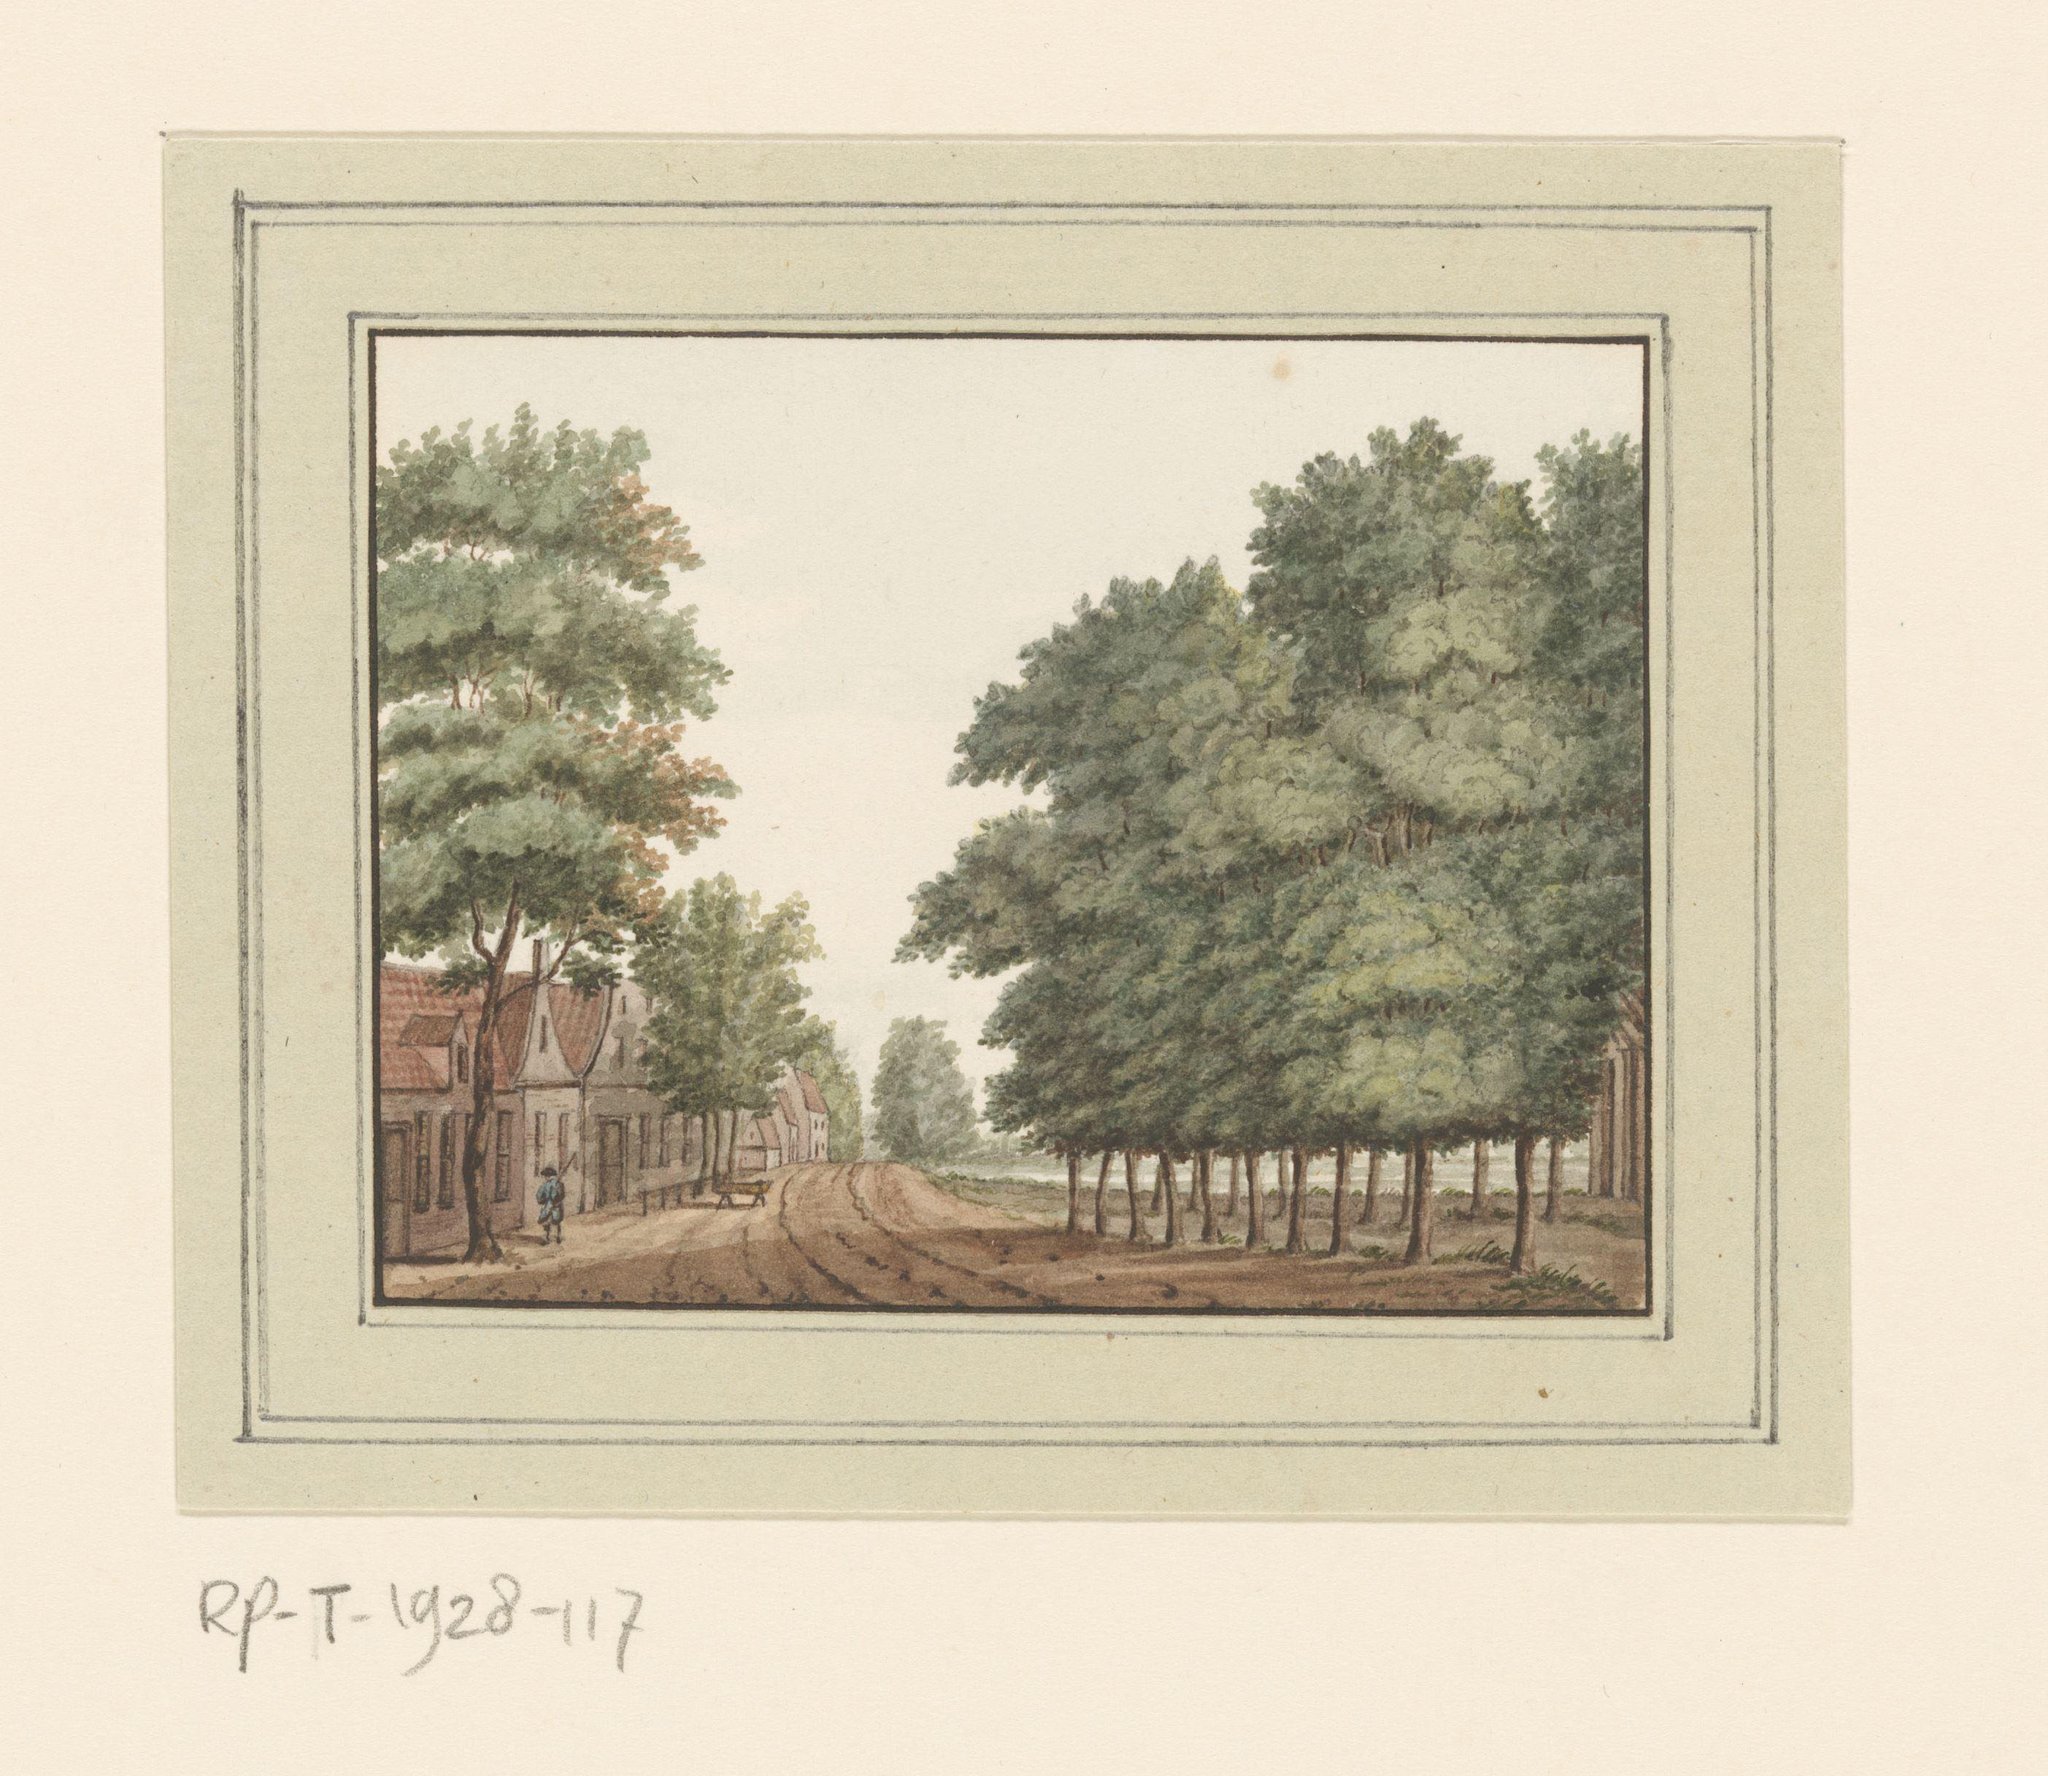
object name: drawing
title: Gezicht op het dorp 's-Graveland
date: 1757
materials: ink, paper, pencil, watercolor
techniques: brush, pen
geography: haarlem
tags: public road in village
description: Mogelijk een kopie naar de prent van Hendrik Spilman, zie RP-P-OB-59.718.